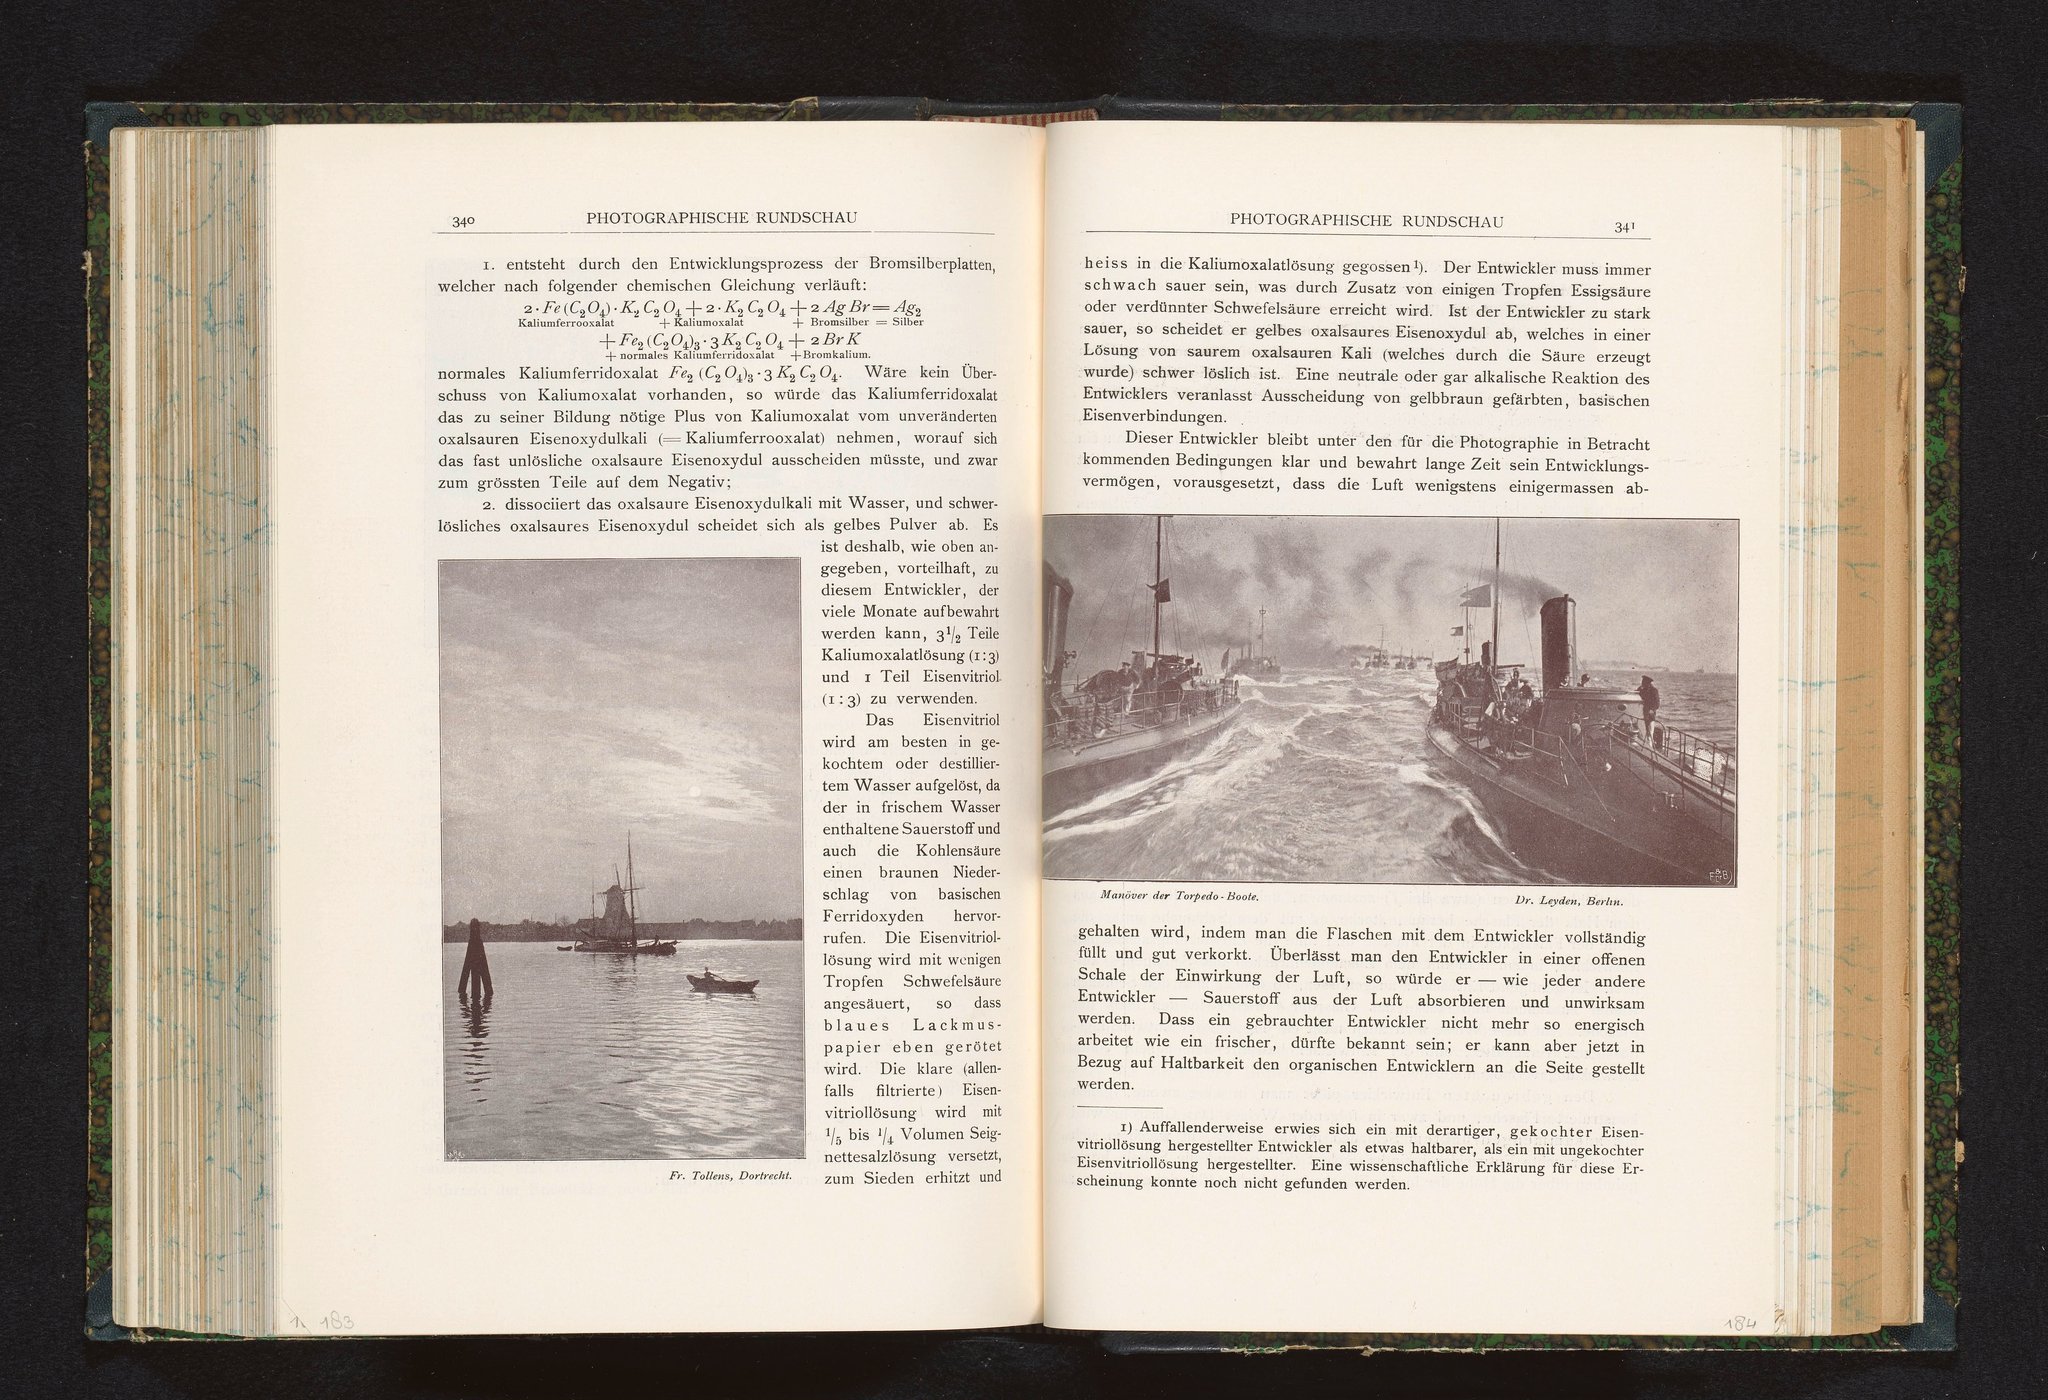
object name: photomechanical print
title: Gezicht op een waterweg, met op de achtergrond een molen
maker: fr. tollens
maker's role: fotograaf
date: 1894-1899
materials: paper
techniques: autotype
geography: berlin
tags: landscapes with waters, waterscapes, seascapes (in the temperate zone), windmill